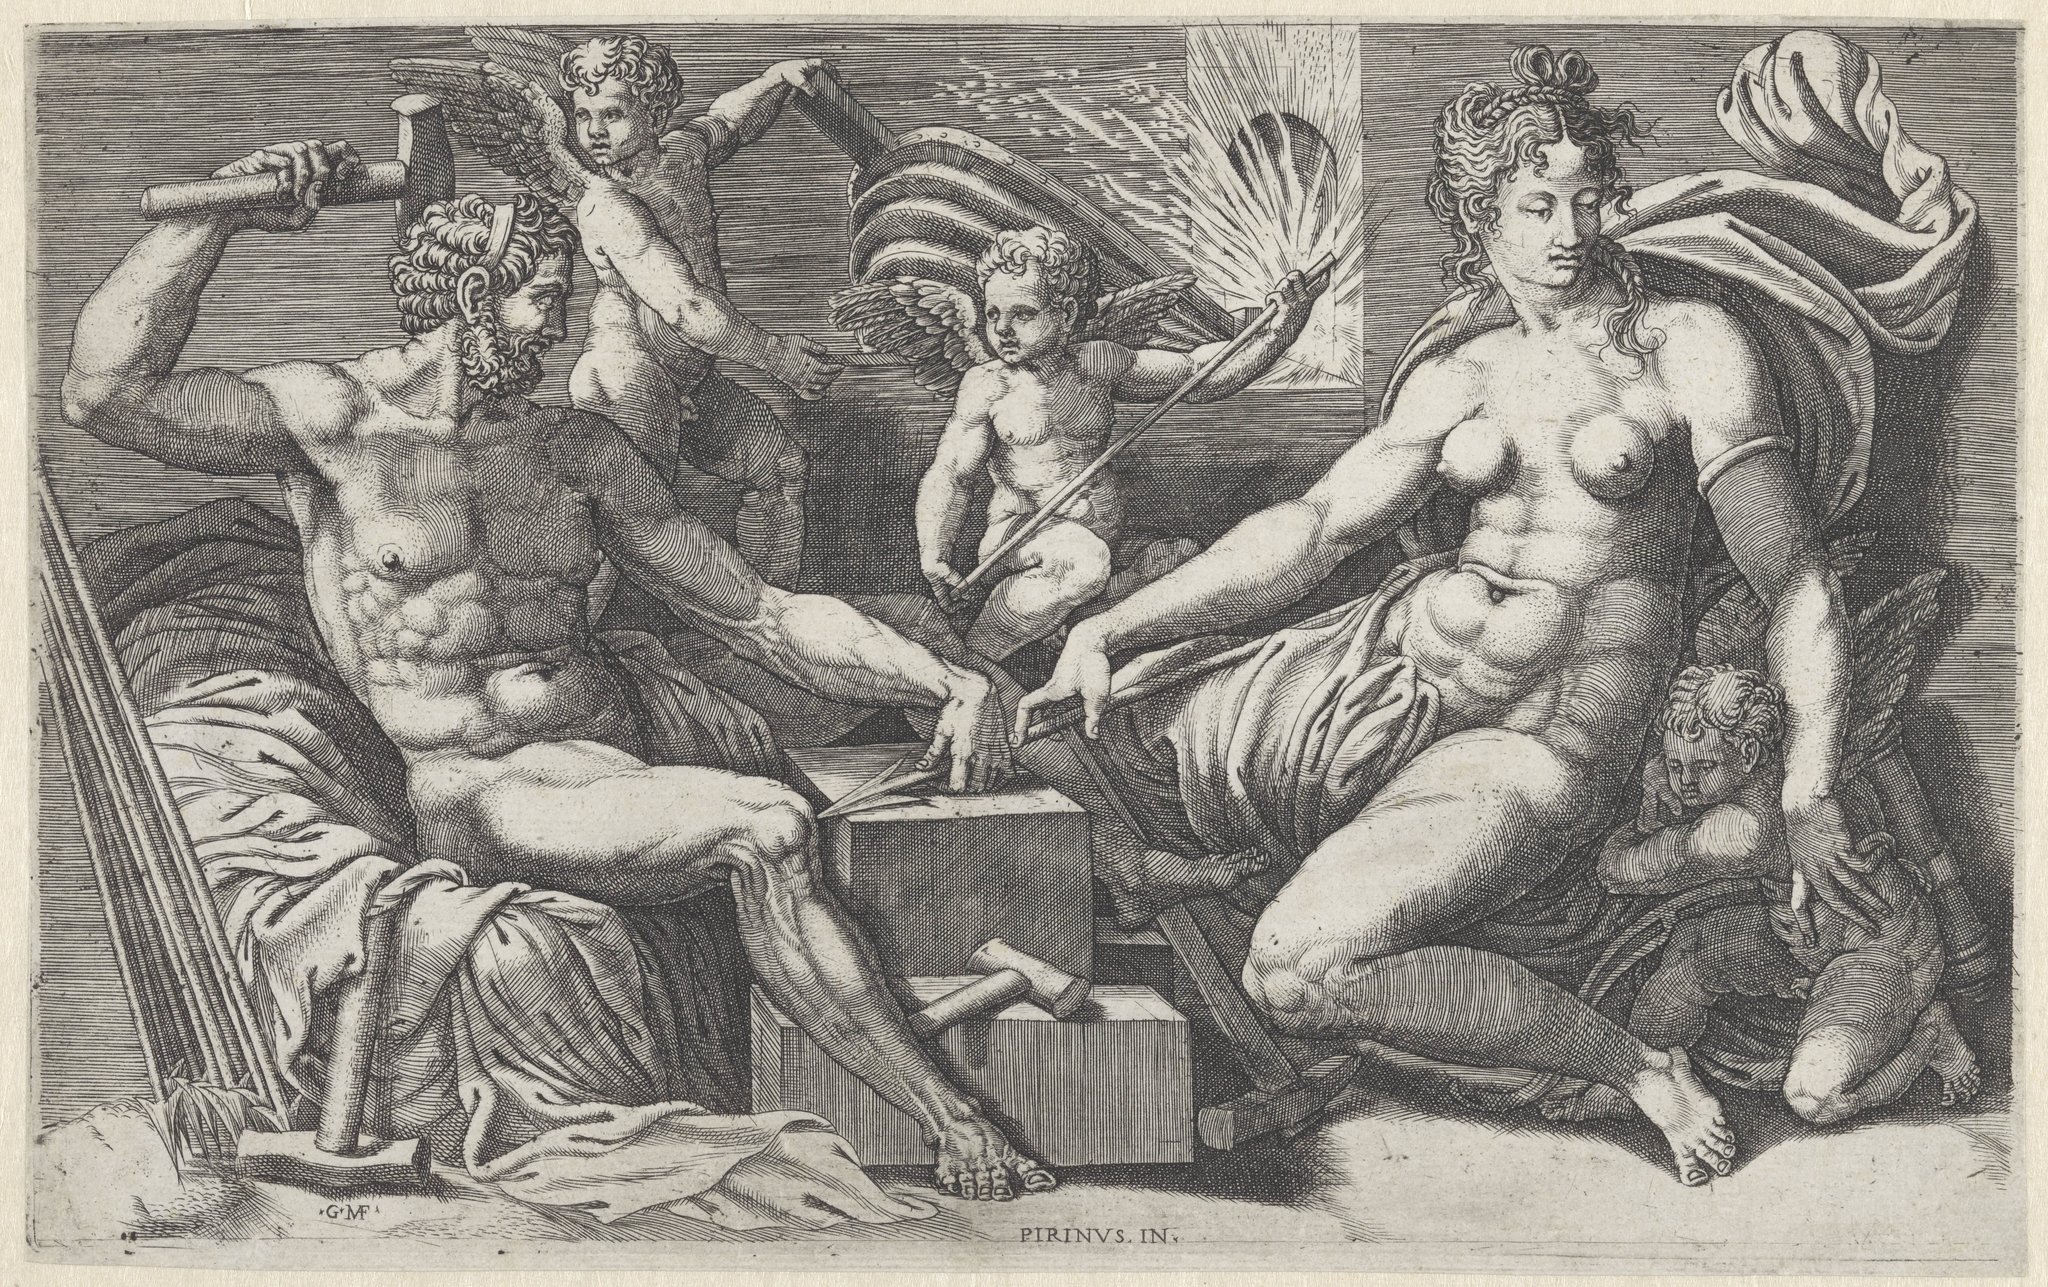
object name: print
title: Venus en Vulcanus in de smidse van Vulcanus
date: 1530-1582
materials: paper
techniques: engraving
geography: italy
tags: (story of) vulcan (hephaestus), vulcan in his smithy, (story of) venus (aphrodite), vulcan and venus, cupids: 'amores', 'amoretti', 'putti'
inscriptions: collector's mark: Lugt 2760, collector's mark: Lugt 2228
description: Venus en Vulcanus in de smidse van Vulcanus. Vulcanus smeedt een pijl. Putti assisteren hem.